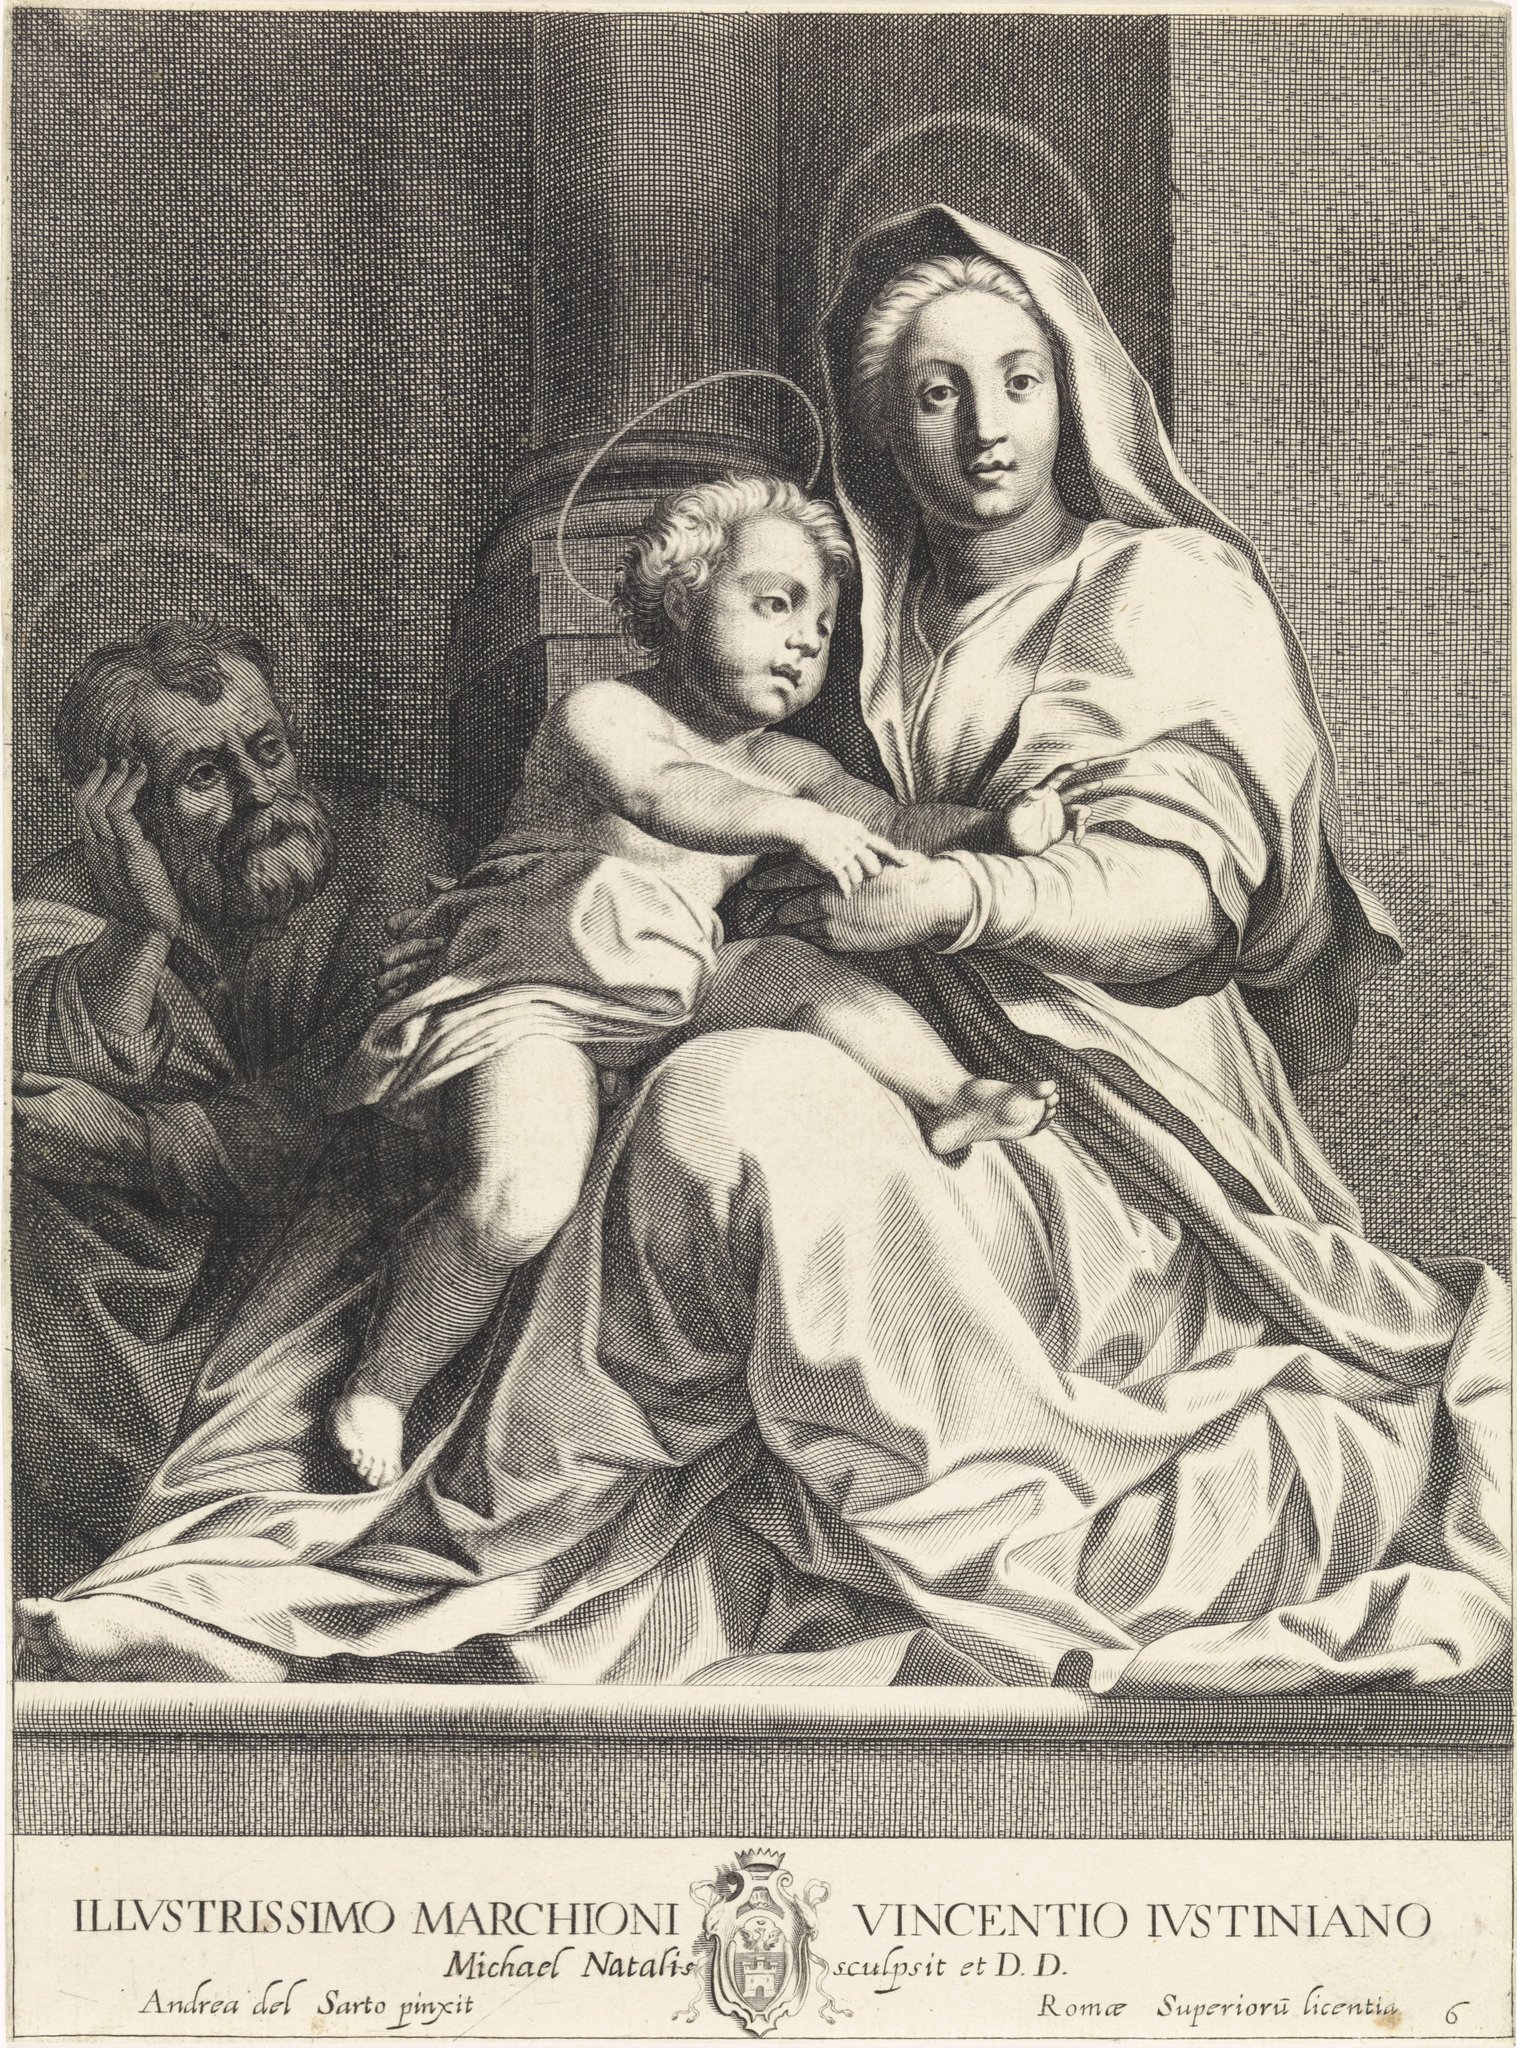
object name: print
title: Heilige Familie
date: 1632-1633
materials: paper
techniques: engraving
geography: rome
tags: holy family, and derived representations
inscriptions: collector's mark: Lugt 240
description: Maria met het Christuskind op haar schoot, Jozef zit naast hen. Midden onder in de marge het wapenschild van Vincenzo Giustiniani. Linksonder genummerd: 6.